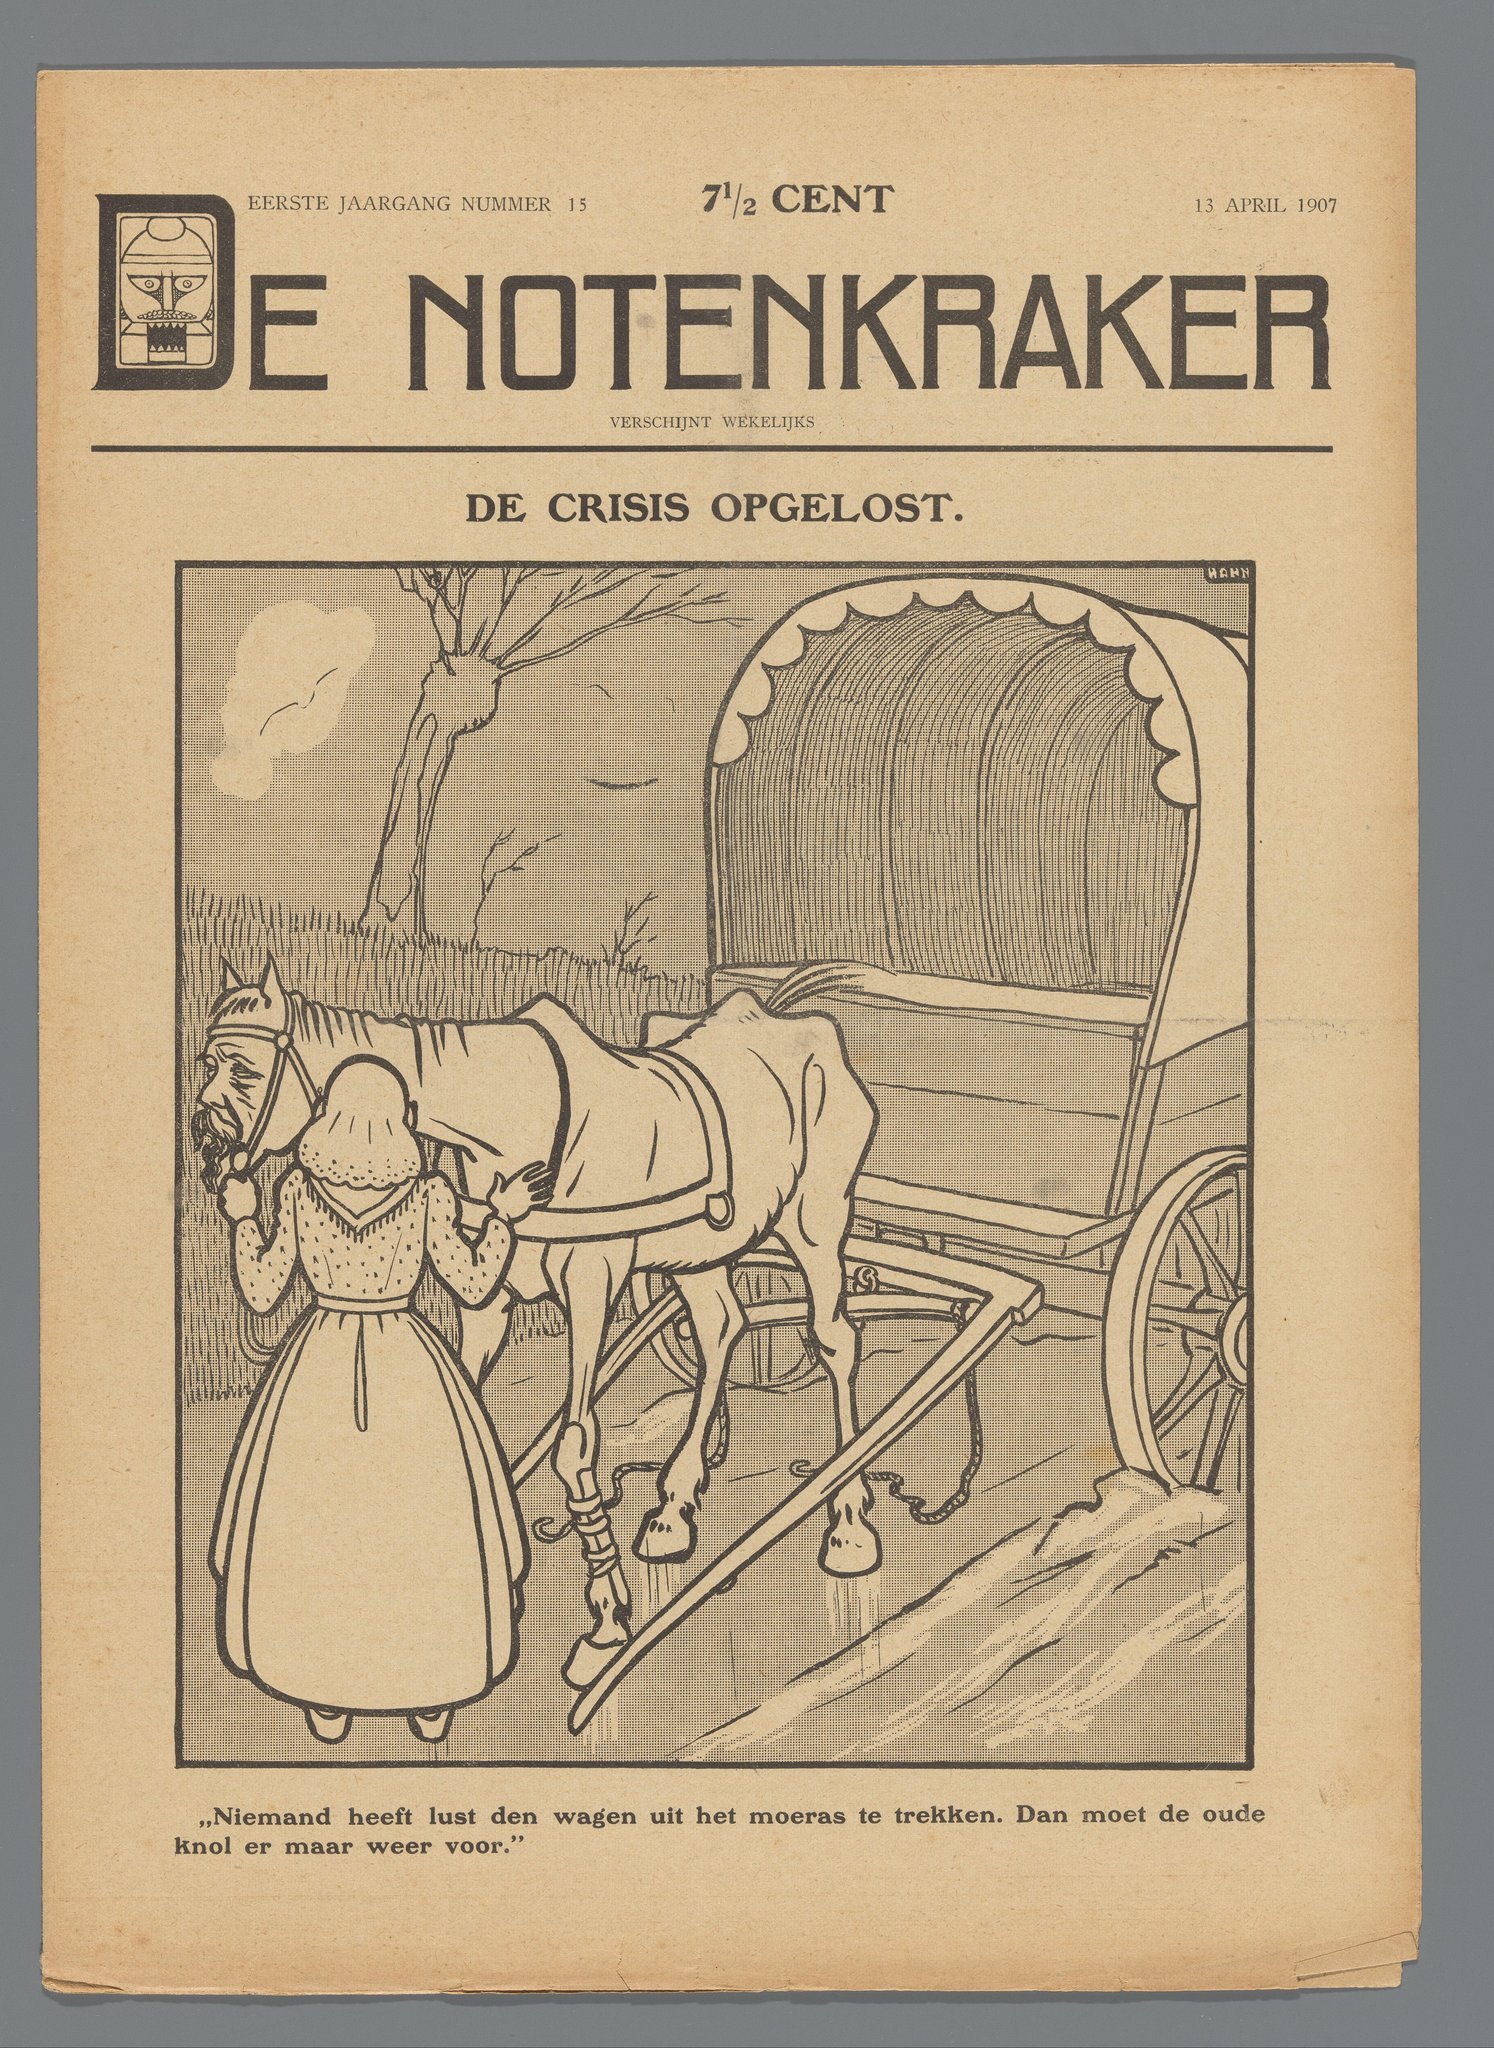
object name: print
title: De Notenkraker, 13 april 1907 / De crisis opgelost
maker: albert hahn (i)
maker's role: draughtsman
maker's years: 1877-1918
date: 1907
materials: paper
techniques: lithograph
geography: netherlands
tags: covered wagon, hooded wagon, political caricatures and satires, netherlands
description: Aflevering van het satirische tijdschrift De Notenkraker van 13 april 1907, eerste jaargang, nummer 15. Omslag met illustratie van een vastgelopen huifkar. Een oud en mank paard met een menselijk gezicht (mogelijk premier Theo de Meester) wordt ervoor gespannen. Onderdeel van een volledige eerste jaargang (1907). Elk nummer bevat 8 bladzijden, deels nog niet losgesneden, met op de voorzijde steeds een spotprent van Albert Hahn, op de overige pagina's prenten van Hahn steeds tussen de tekst. In de letter 'D' van de titel is een kop van een zgn. notenkraker afgebeeld.